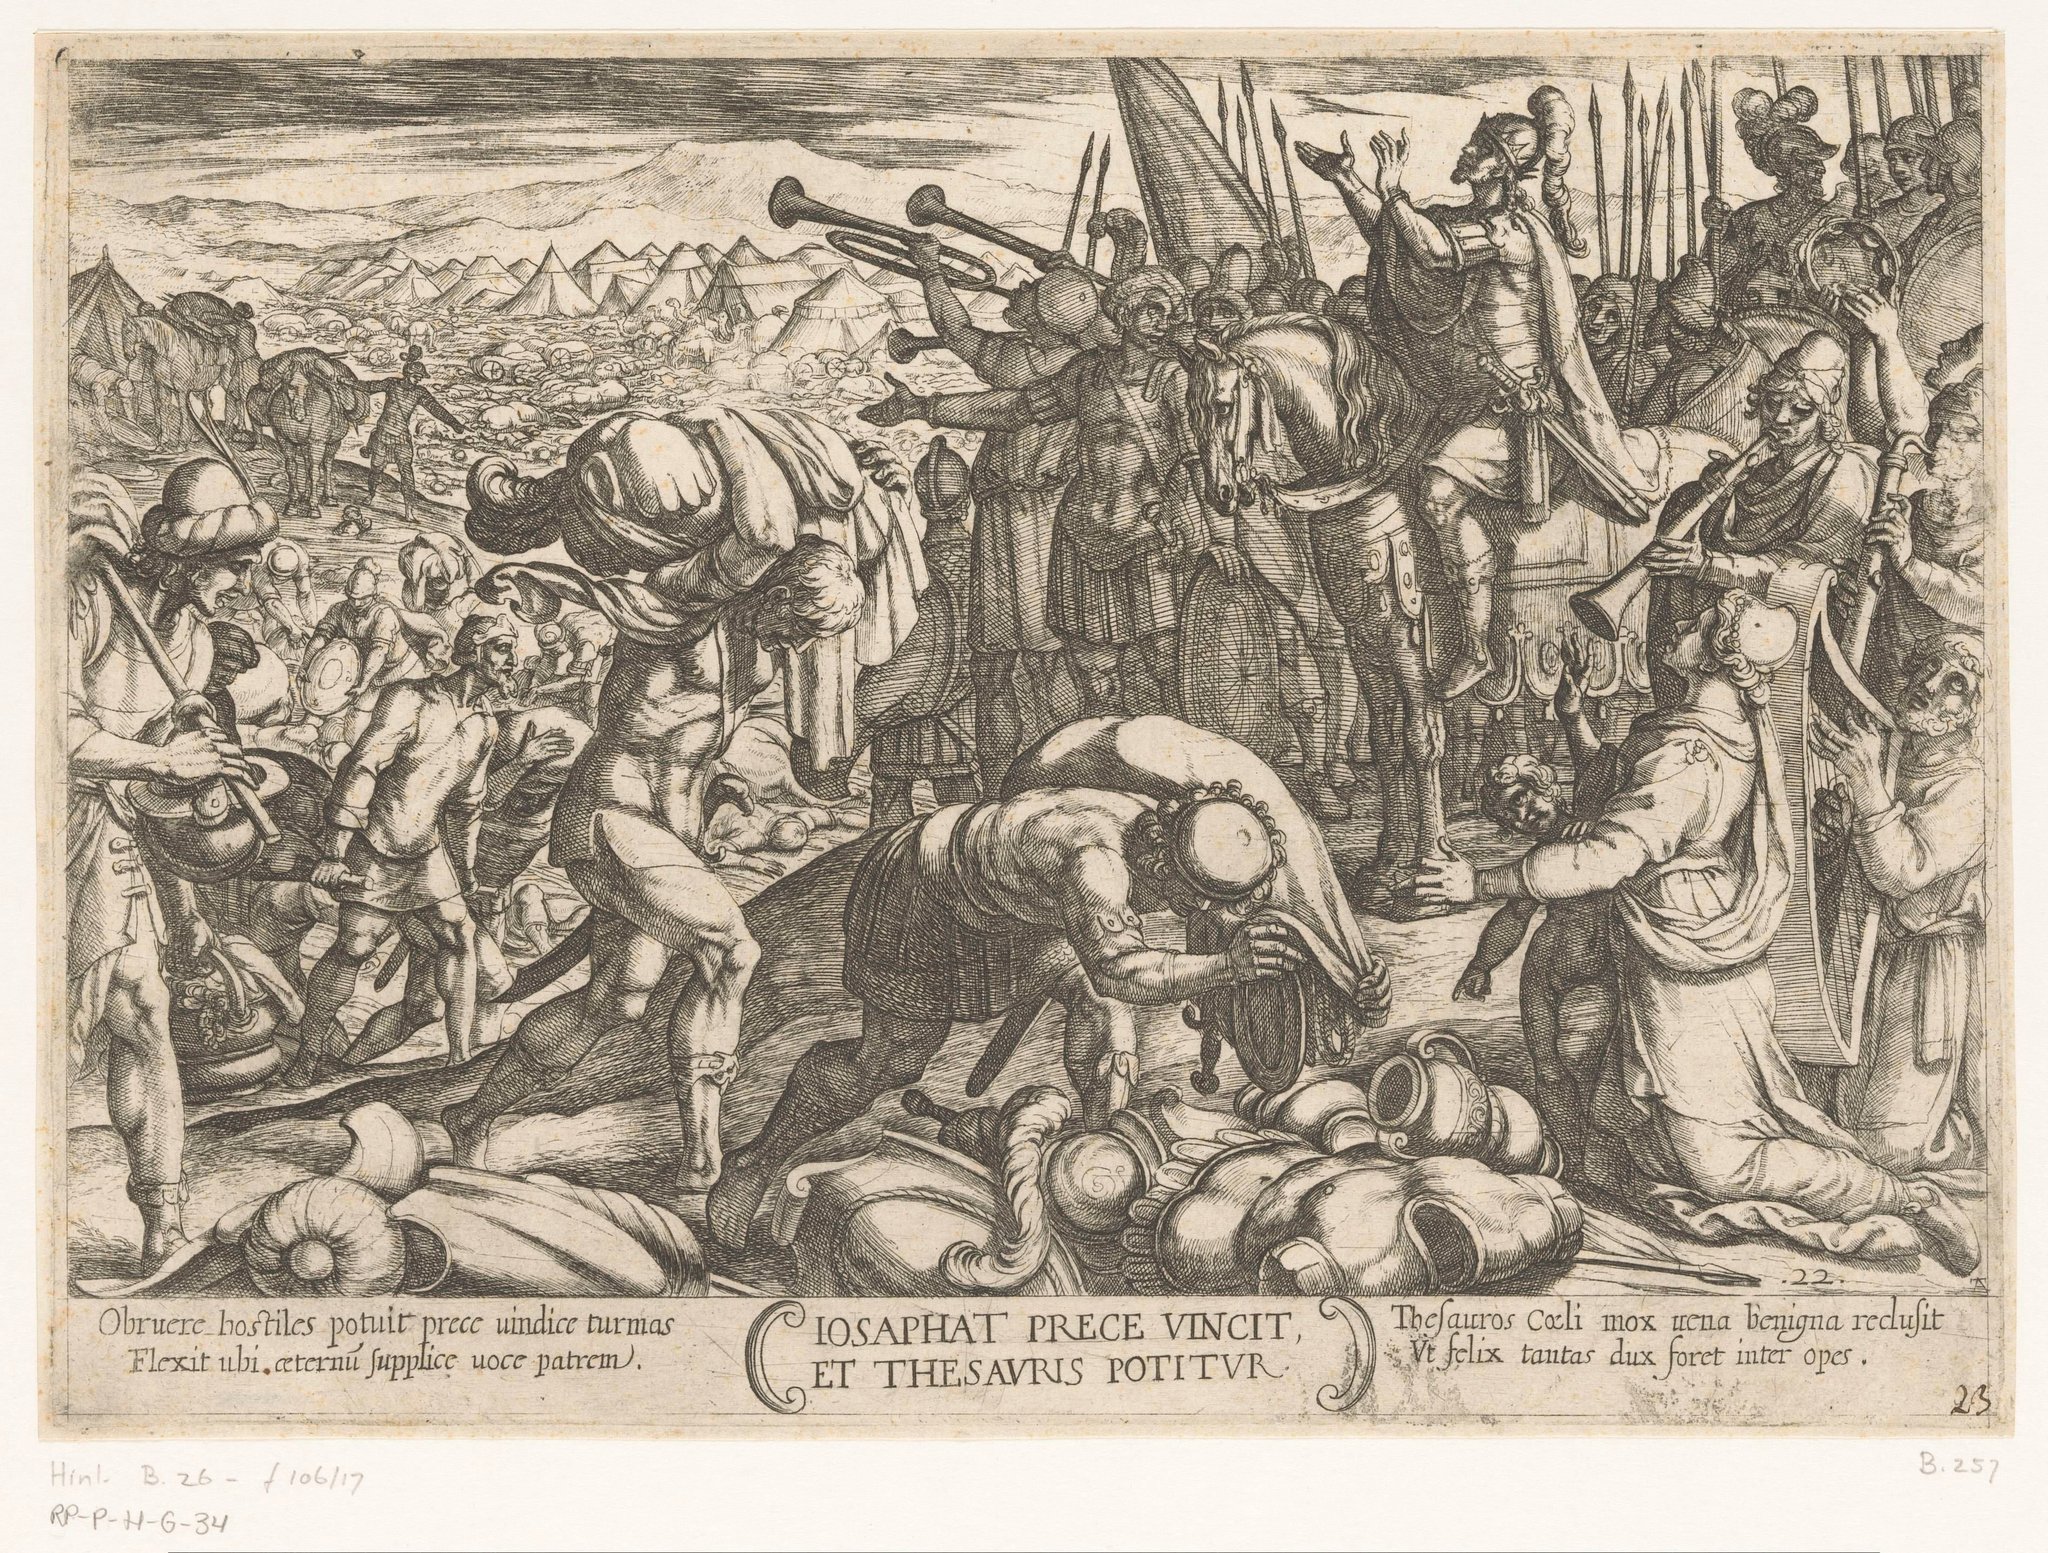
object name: print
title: Oudtestamentische strijdscènes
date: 1613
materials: paper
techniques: etching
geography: italy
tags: story of jehoshaphat (josaphat), son of asa, king of judah (1 kings 22:41-51; 2 chronicles 17-20), the gathering of the spoils ~ war against the moabites, maonites and the children of ammon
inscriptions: collector's mark: ‘Hinloopen’, number: ‘23’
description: Josaphat zit op zijn paard en wordt omringd door zijn soldaten. Hij dankt God voor zijn overwinning. Op de voorgrond links soldaten die de oorlogsbuit verzamelen. Titel en onderschrift in het Latijn in de ondermarge.